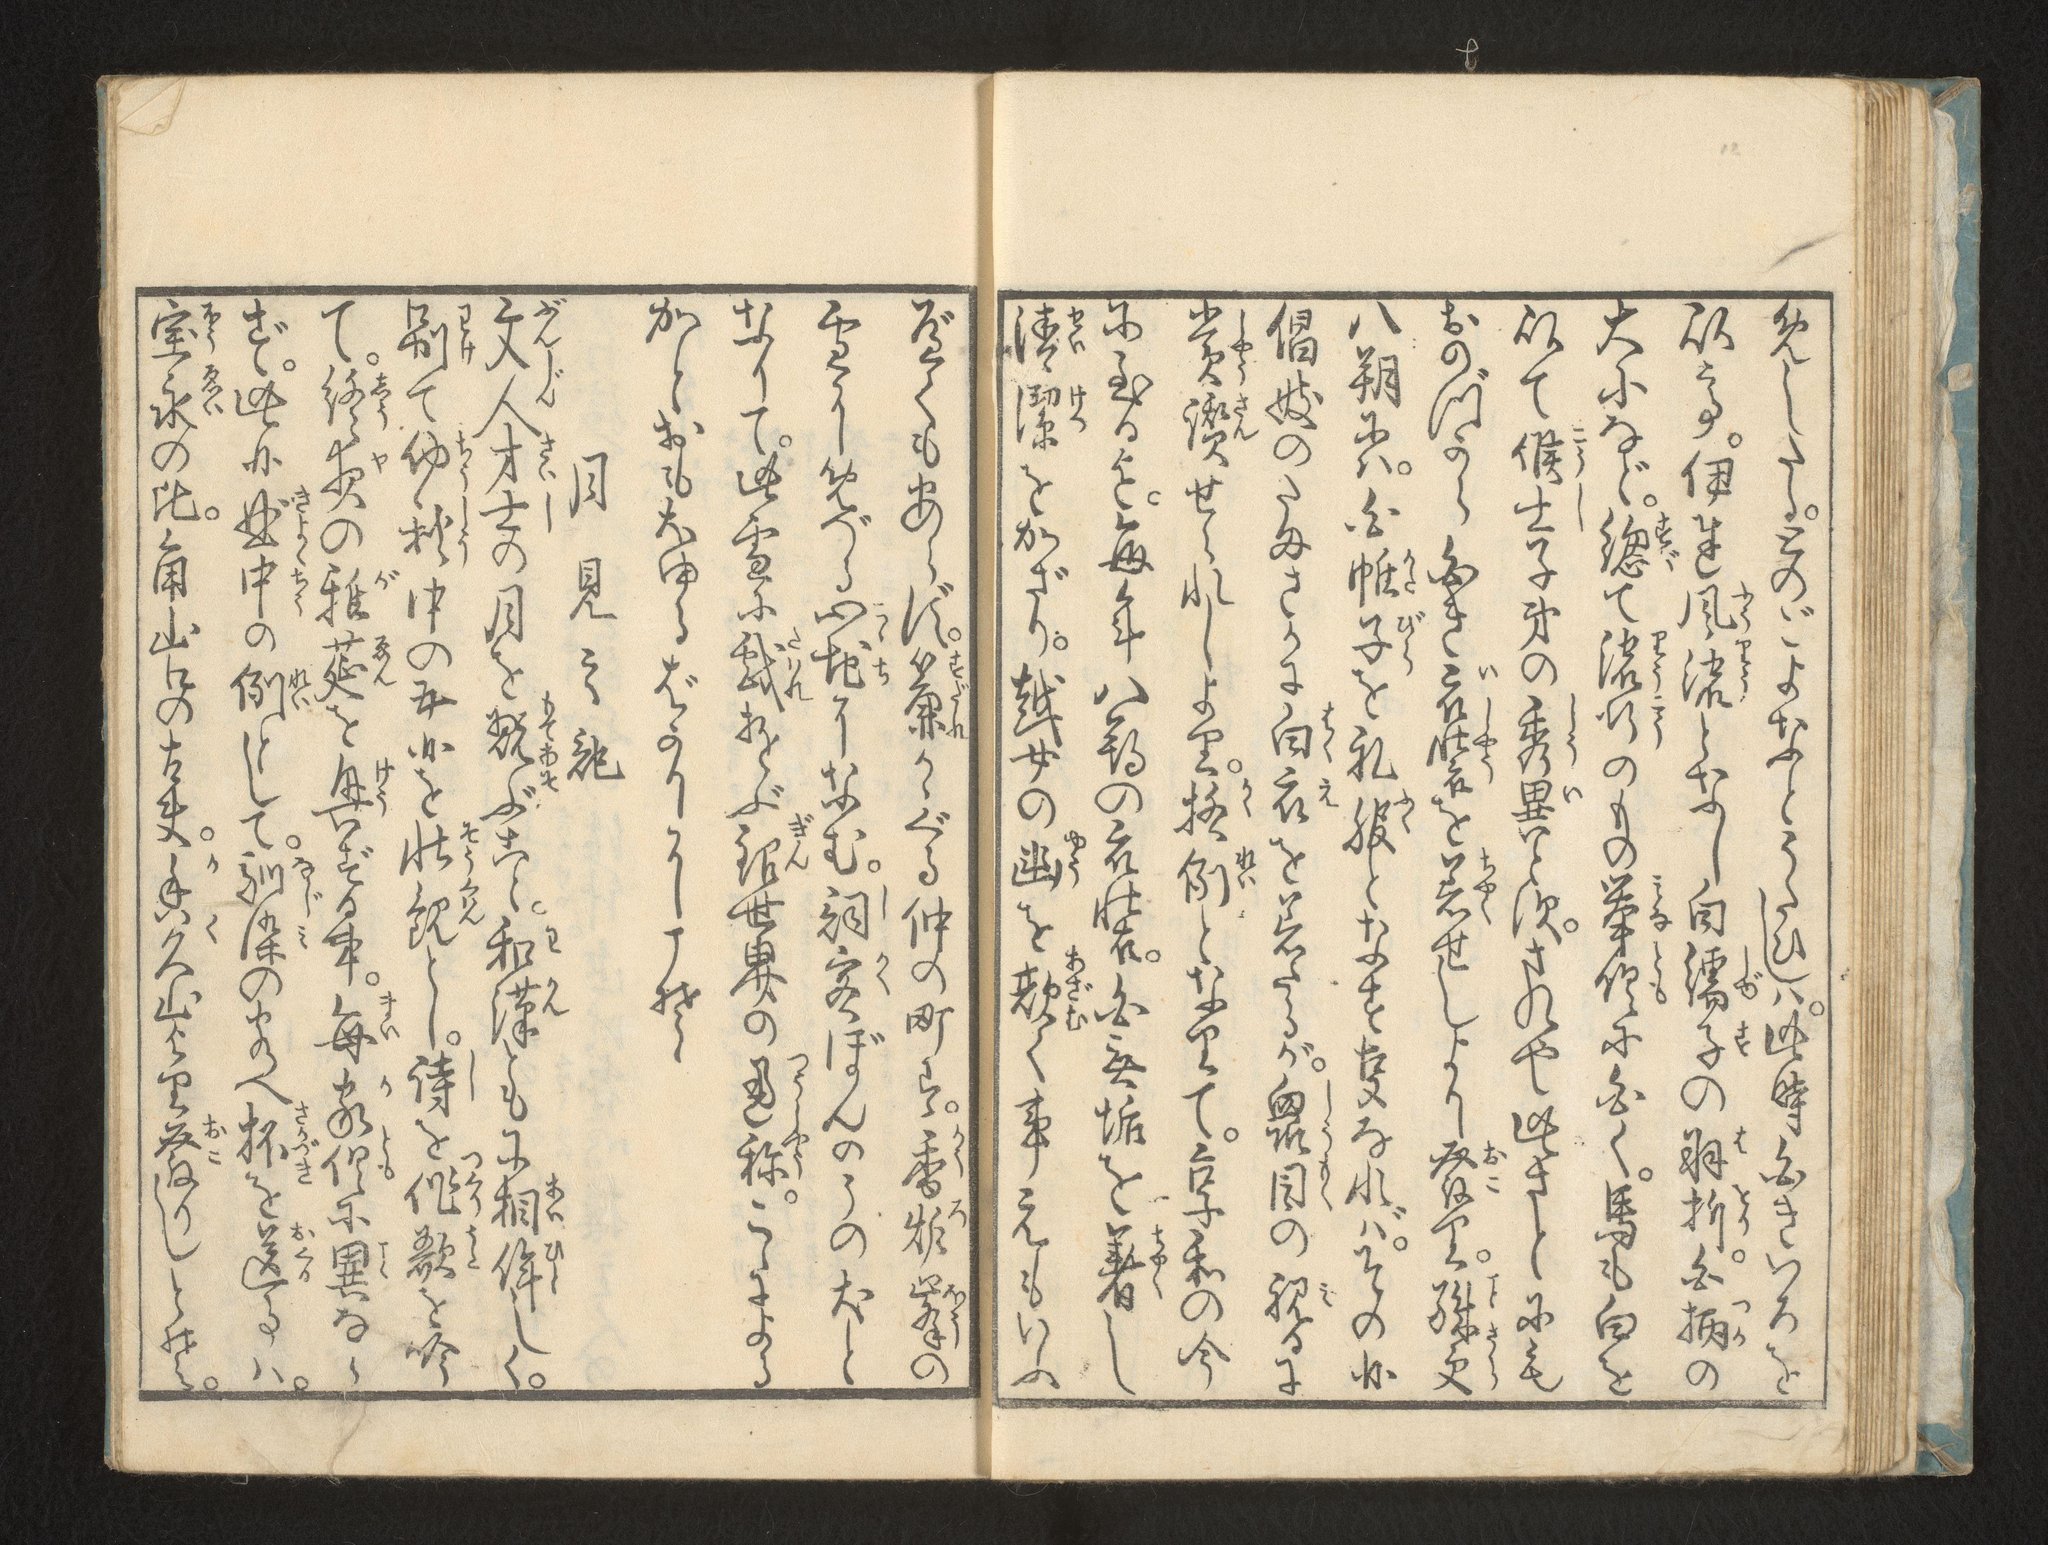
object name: page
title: tekst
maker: jippensha ikku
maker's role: schrijver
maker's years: 1765-1831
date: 1804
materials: paper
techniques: woodcut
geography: edo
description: Derde en vierde tekstpagina van deel twee van Utamaro`s boek: Gebeurtenissen in de lusthuizen gedurende het jaar.